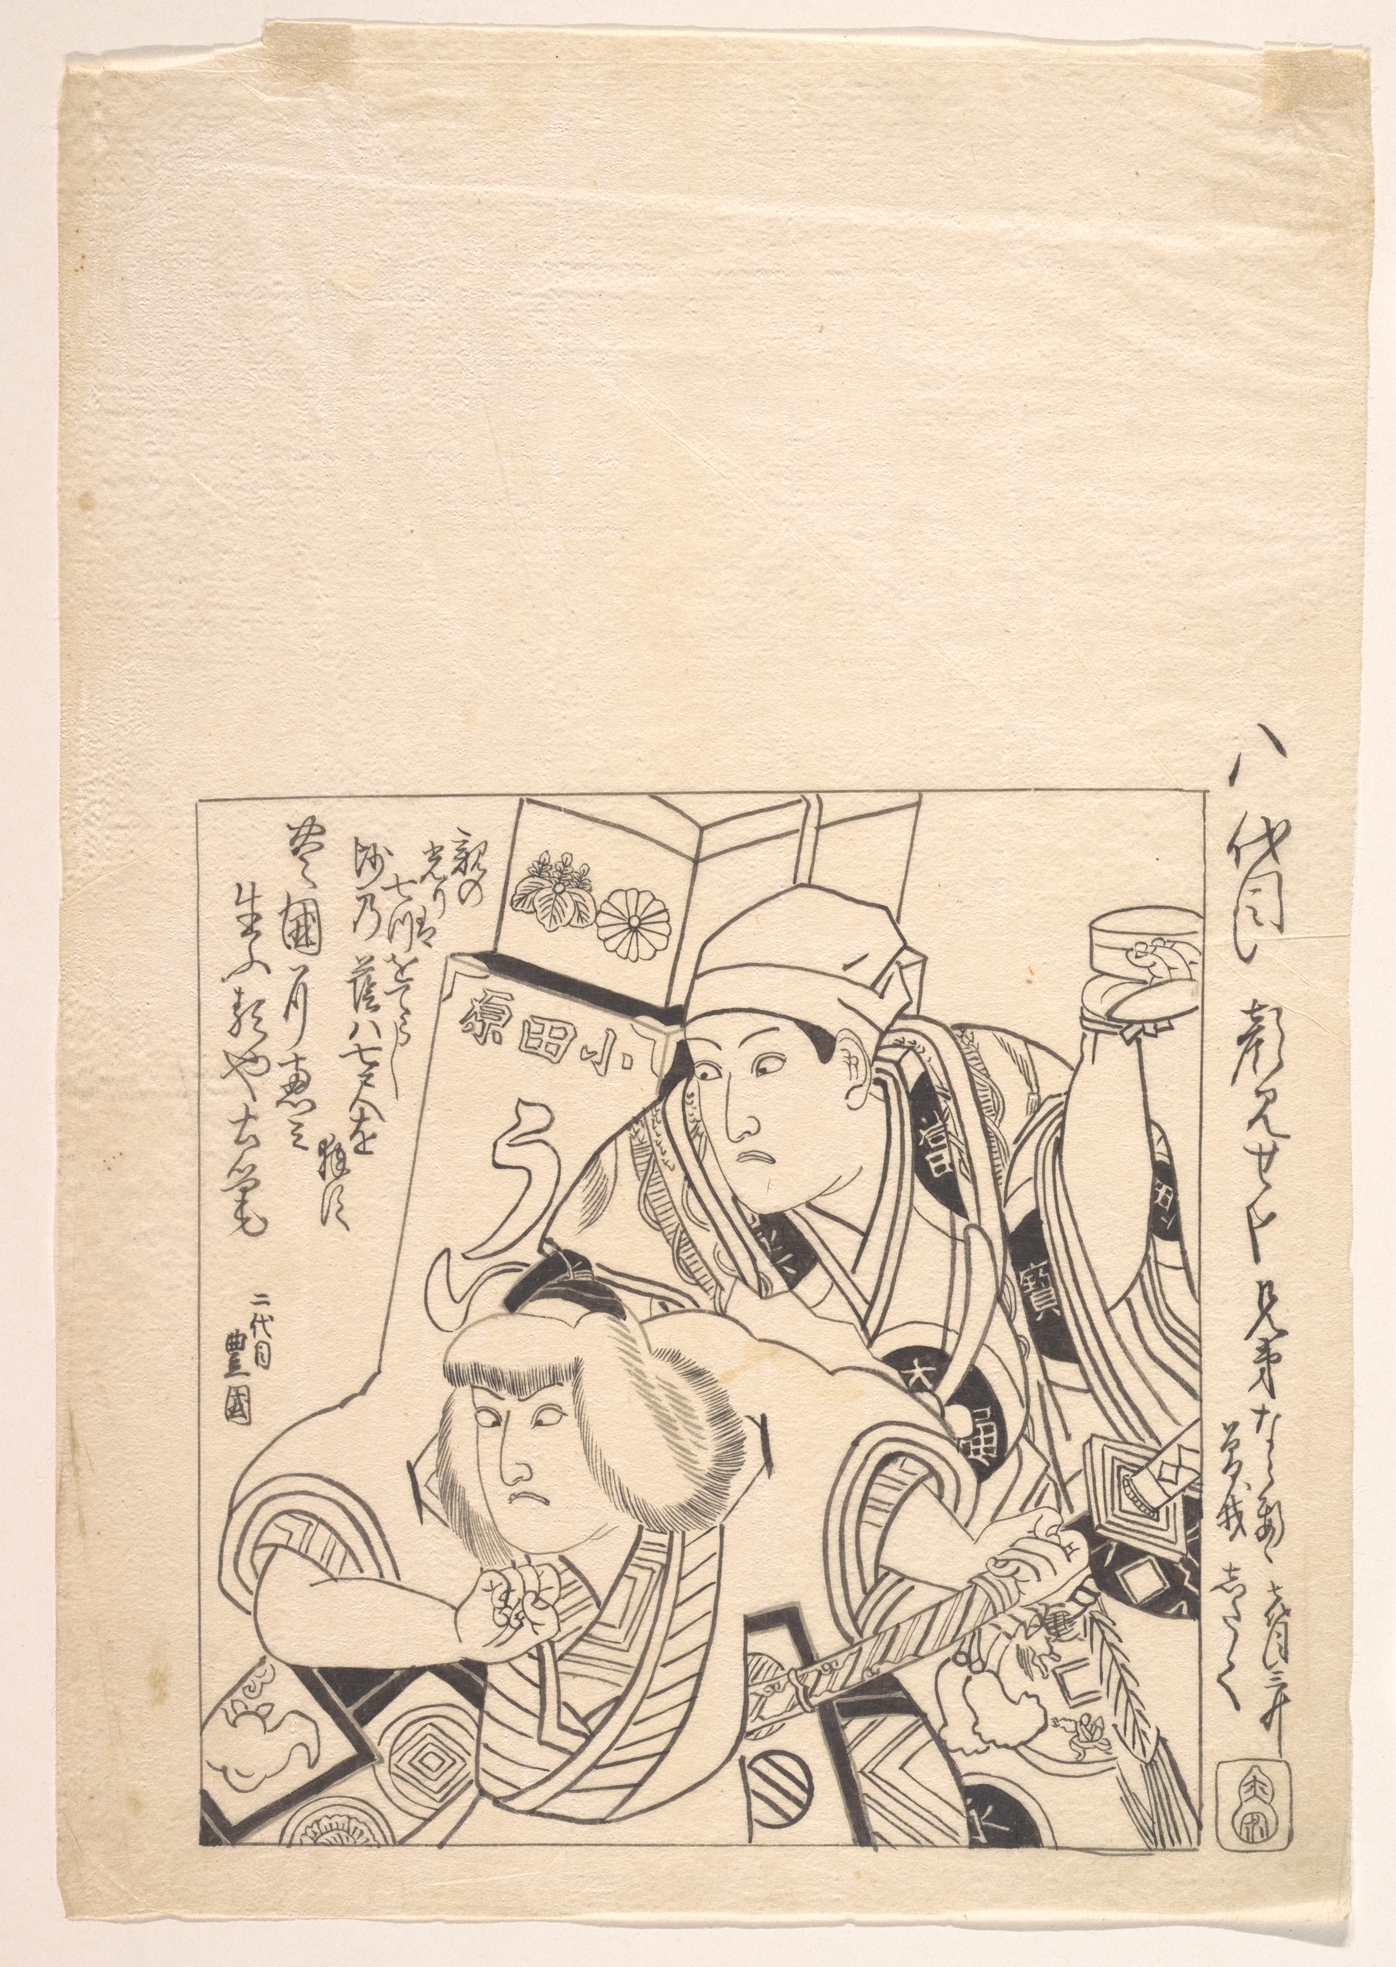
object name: print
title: Shitaku and Sansho VII in Soga Kyodai (a Kabuki Play of the Soga Brothers)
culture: japanese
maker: utagawa toyokuni i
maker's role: artist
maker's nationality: japanese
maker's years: 1769-1825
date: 1769-1825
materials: ink, paper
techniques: woodblock print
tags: men,actors